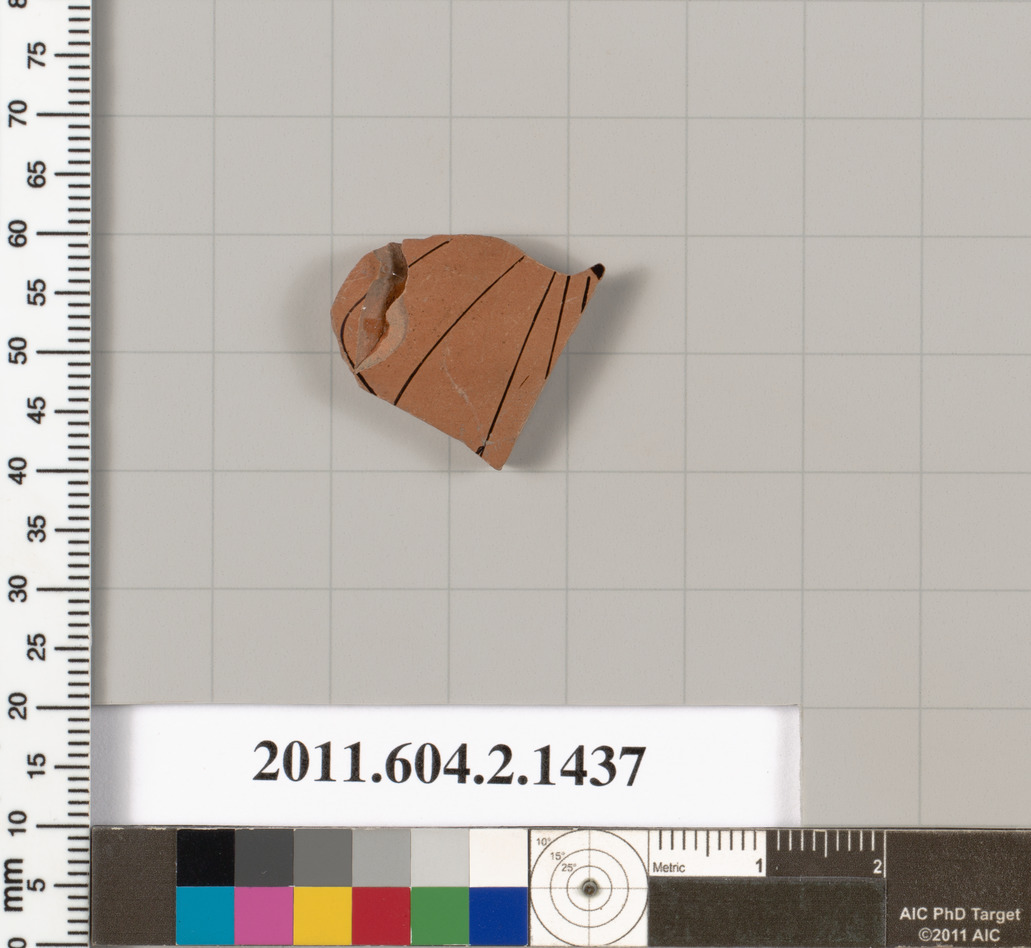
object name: skyphos fragment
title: Terracotta fragment of a skyphos (deep drinking cup)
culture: greek, attic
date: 475-451 BCE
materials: terracotta